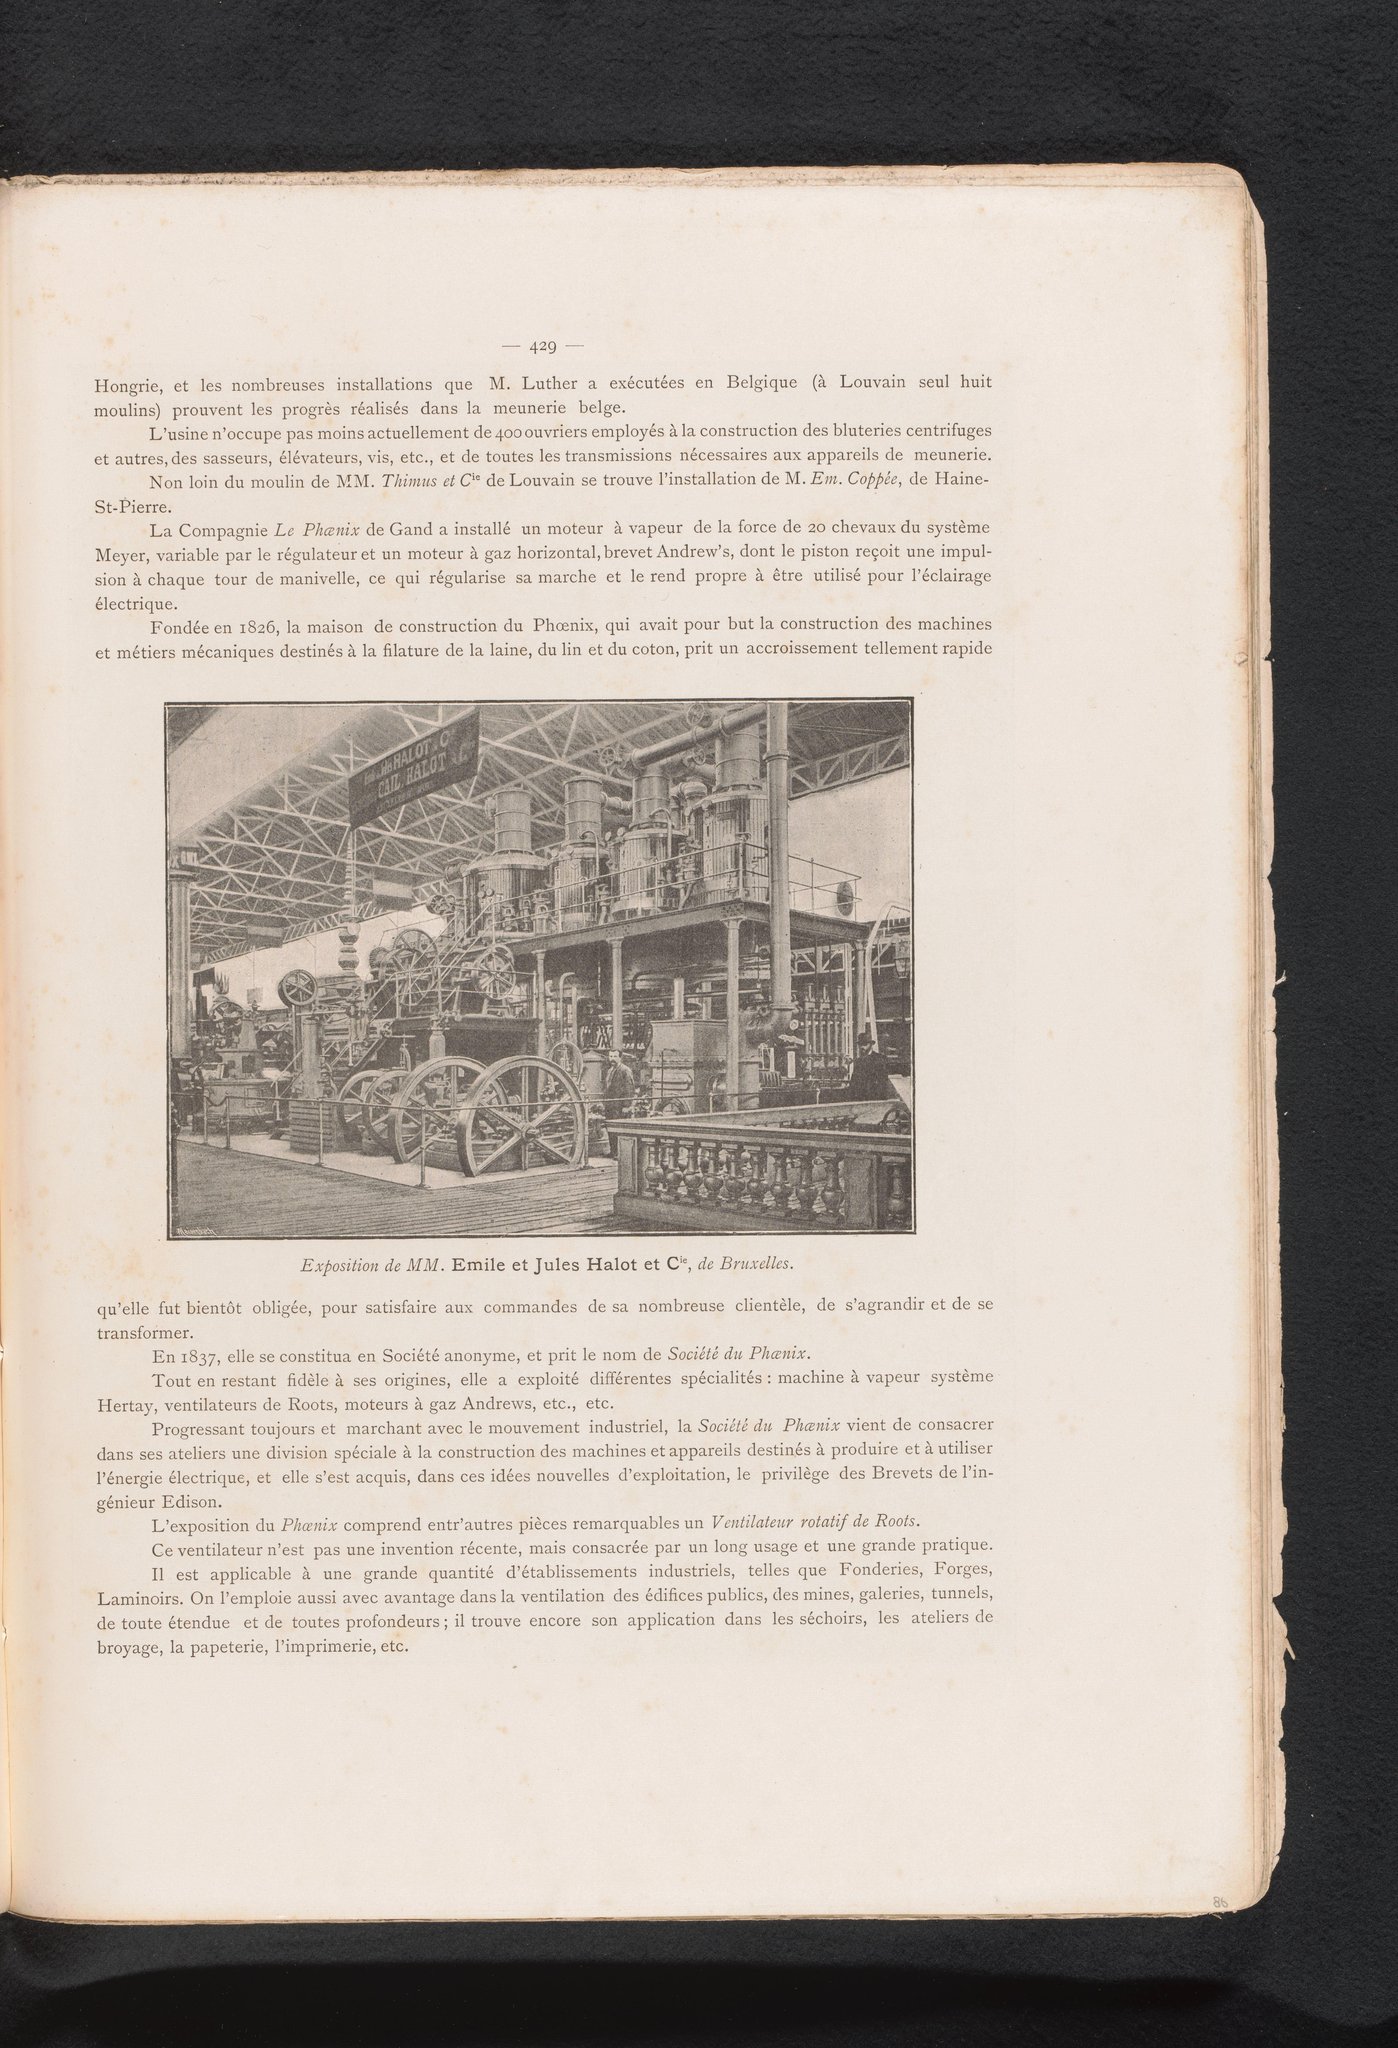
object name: photomechanical print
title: Exposition de MM. Emile et Jules Halot et Cie, de Bruxelles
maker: Anonymous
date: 1880-1885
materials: paper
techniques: autotype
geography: antwerp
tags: world fair, world exhibition, antwerp